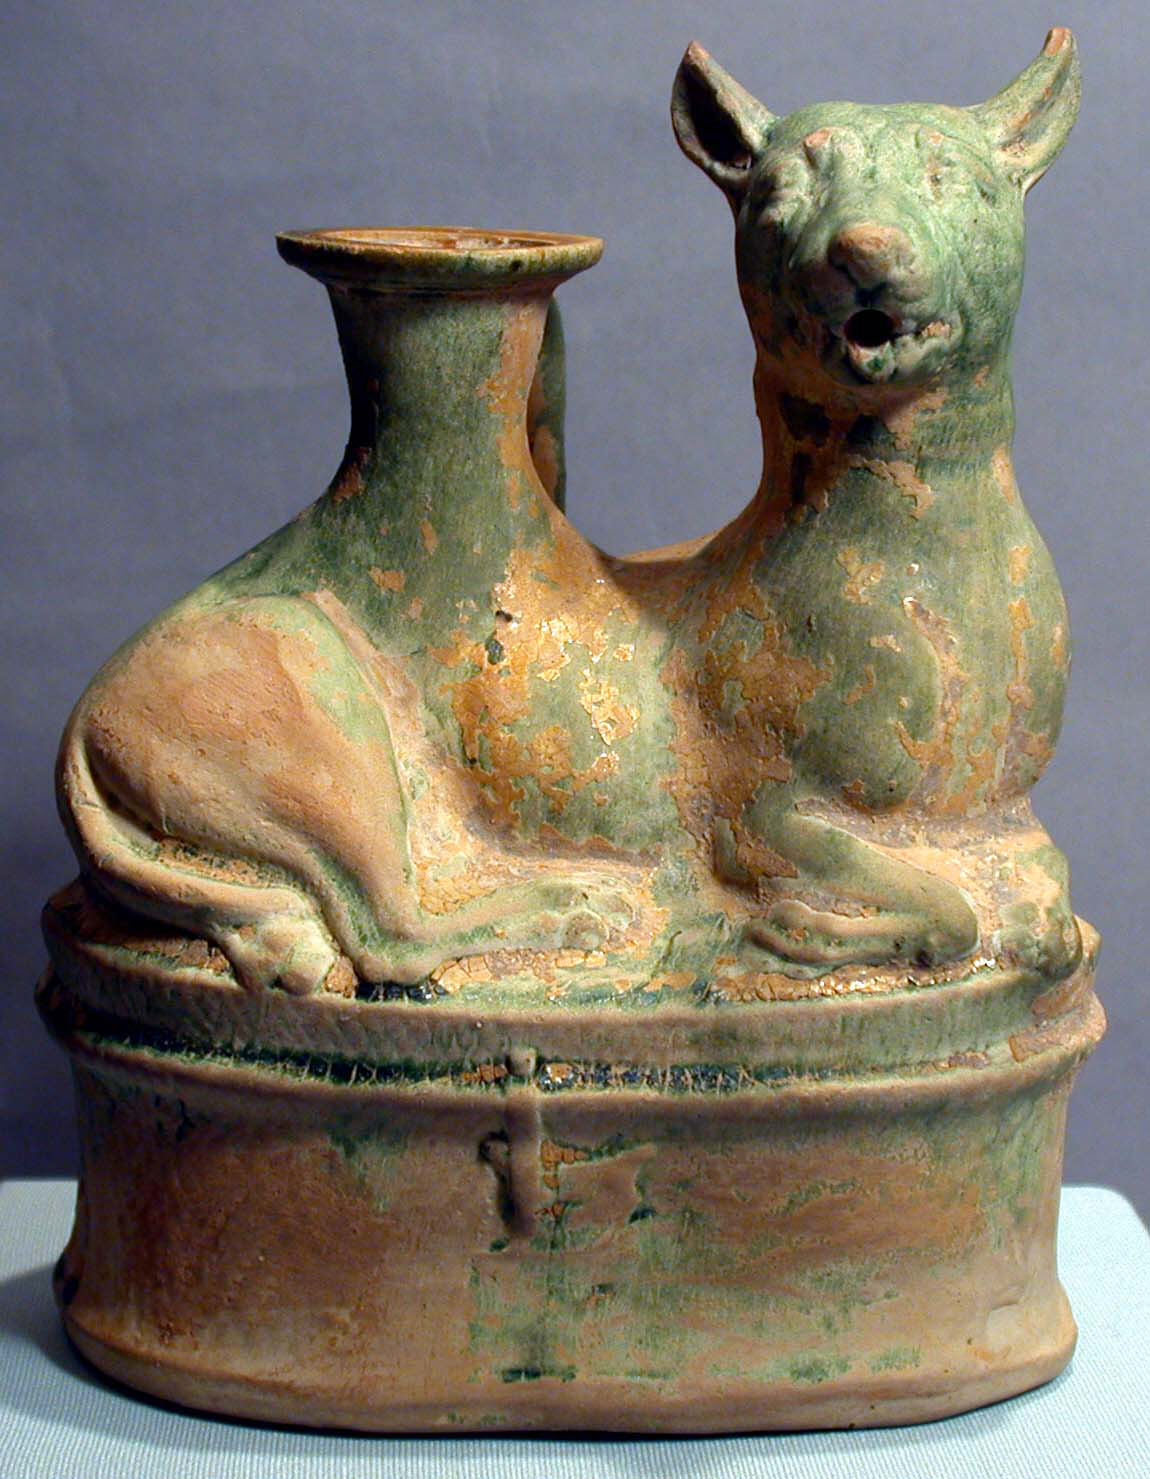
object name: askos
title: Terracotta askos in the shape of a reclining dog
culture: roman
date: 1-100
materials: terracotta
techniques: glazing